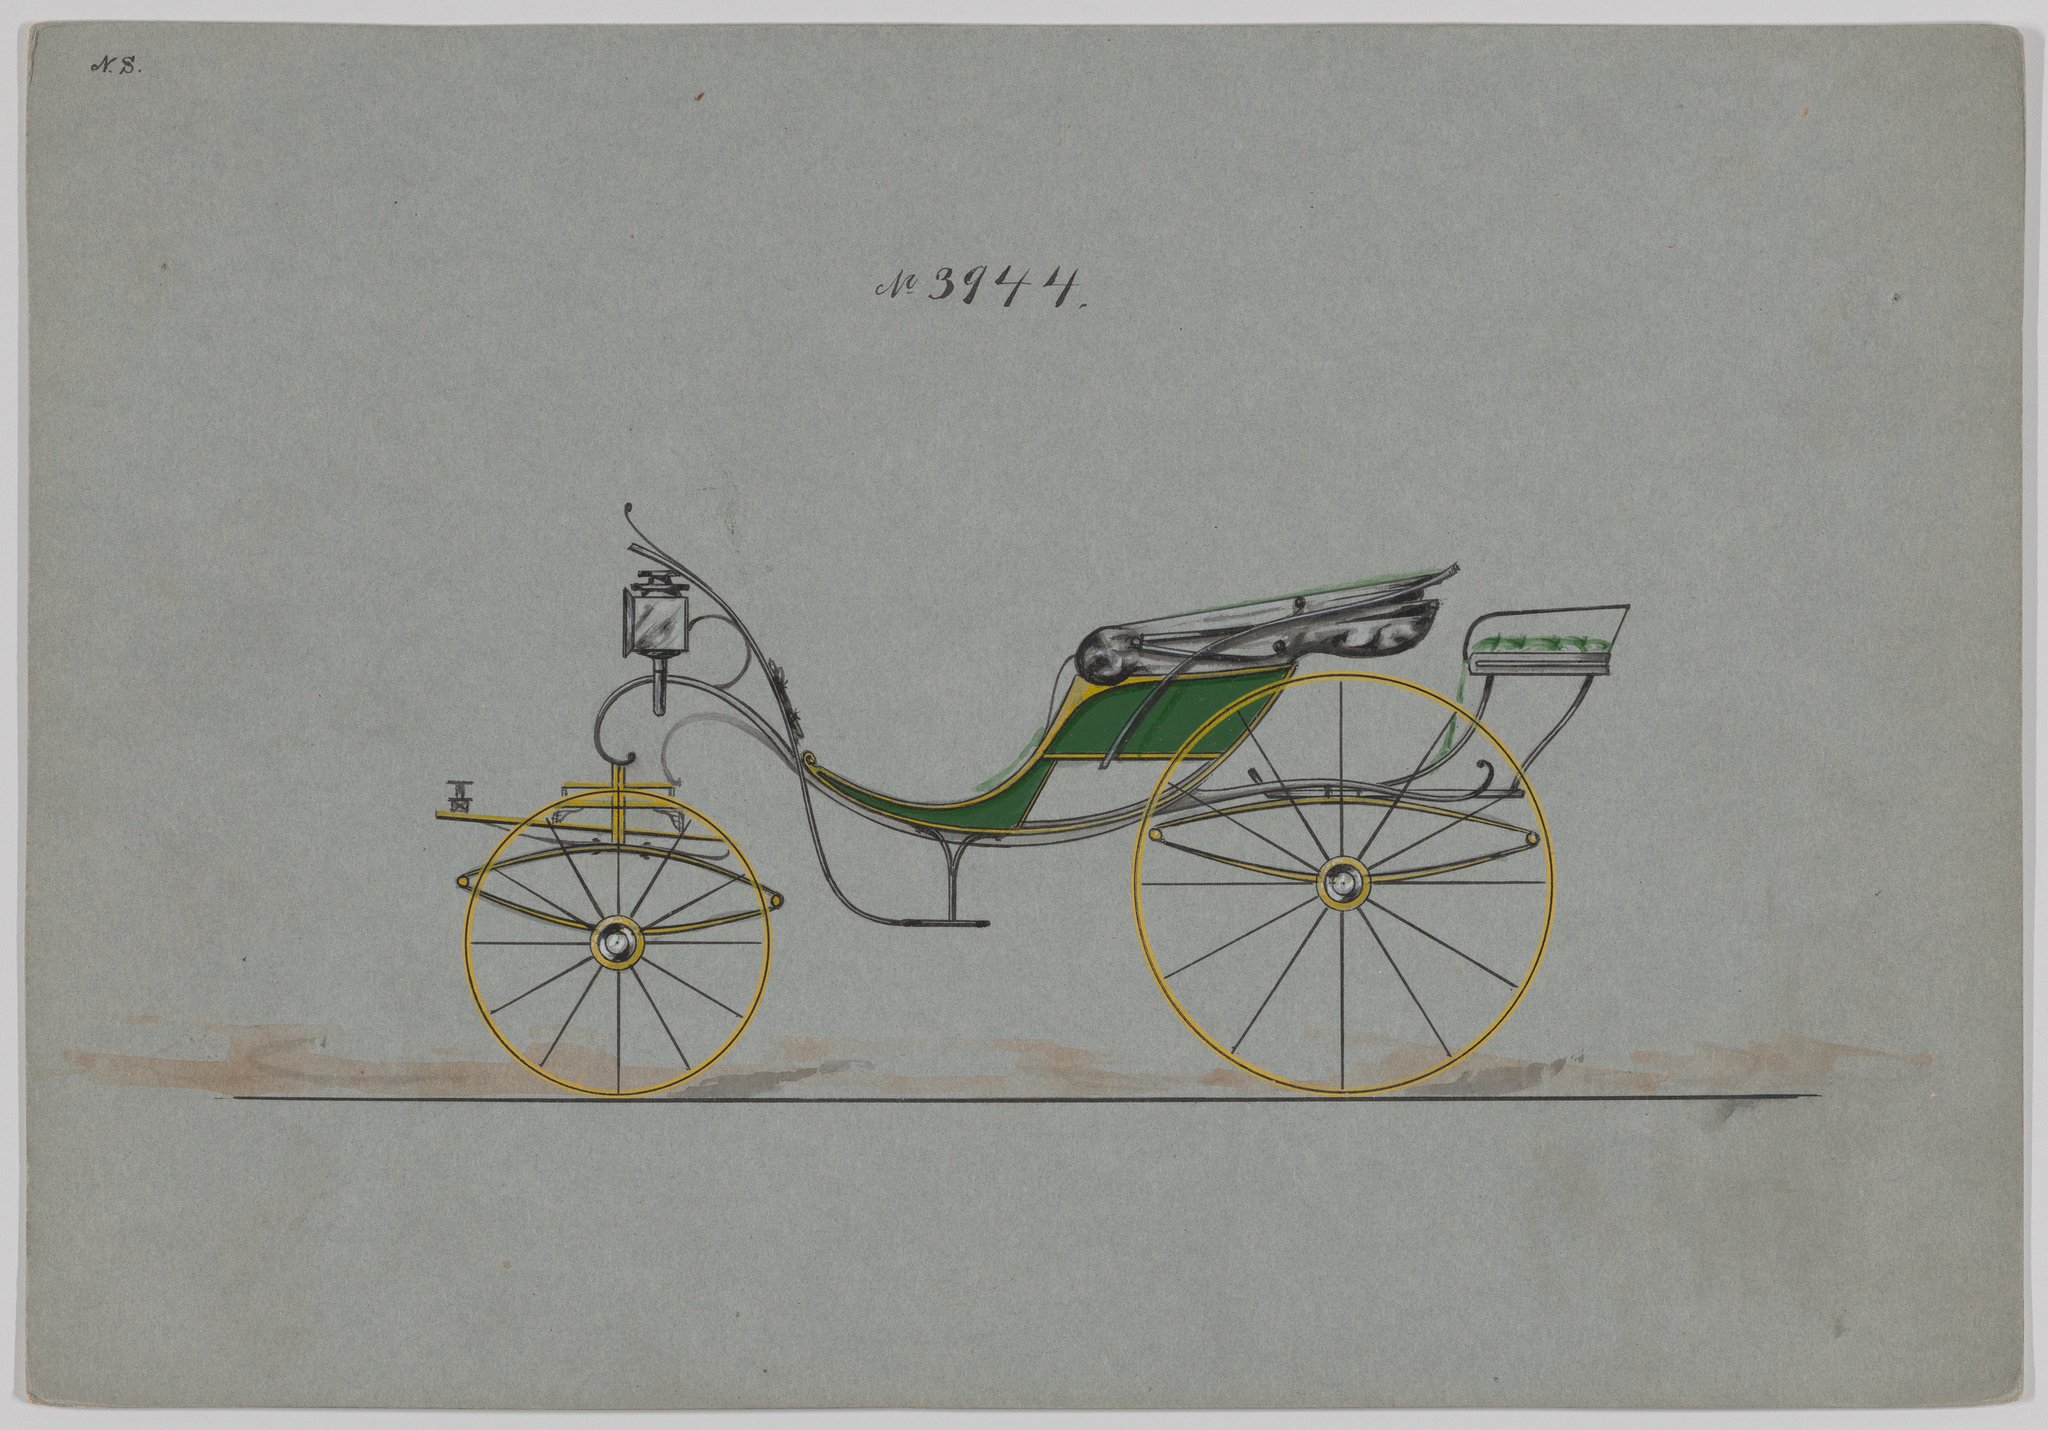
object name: drawing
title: Design for Pony Phaeton, no. 3944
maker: brewster & co.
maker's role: manufacturer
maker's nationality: american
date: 1885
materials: gouache, gum arabic, ink, watercolor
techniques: pen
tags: carriages